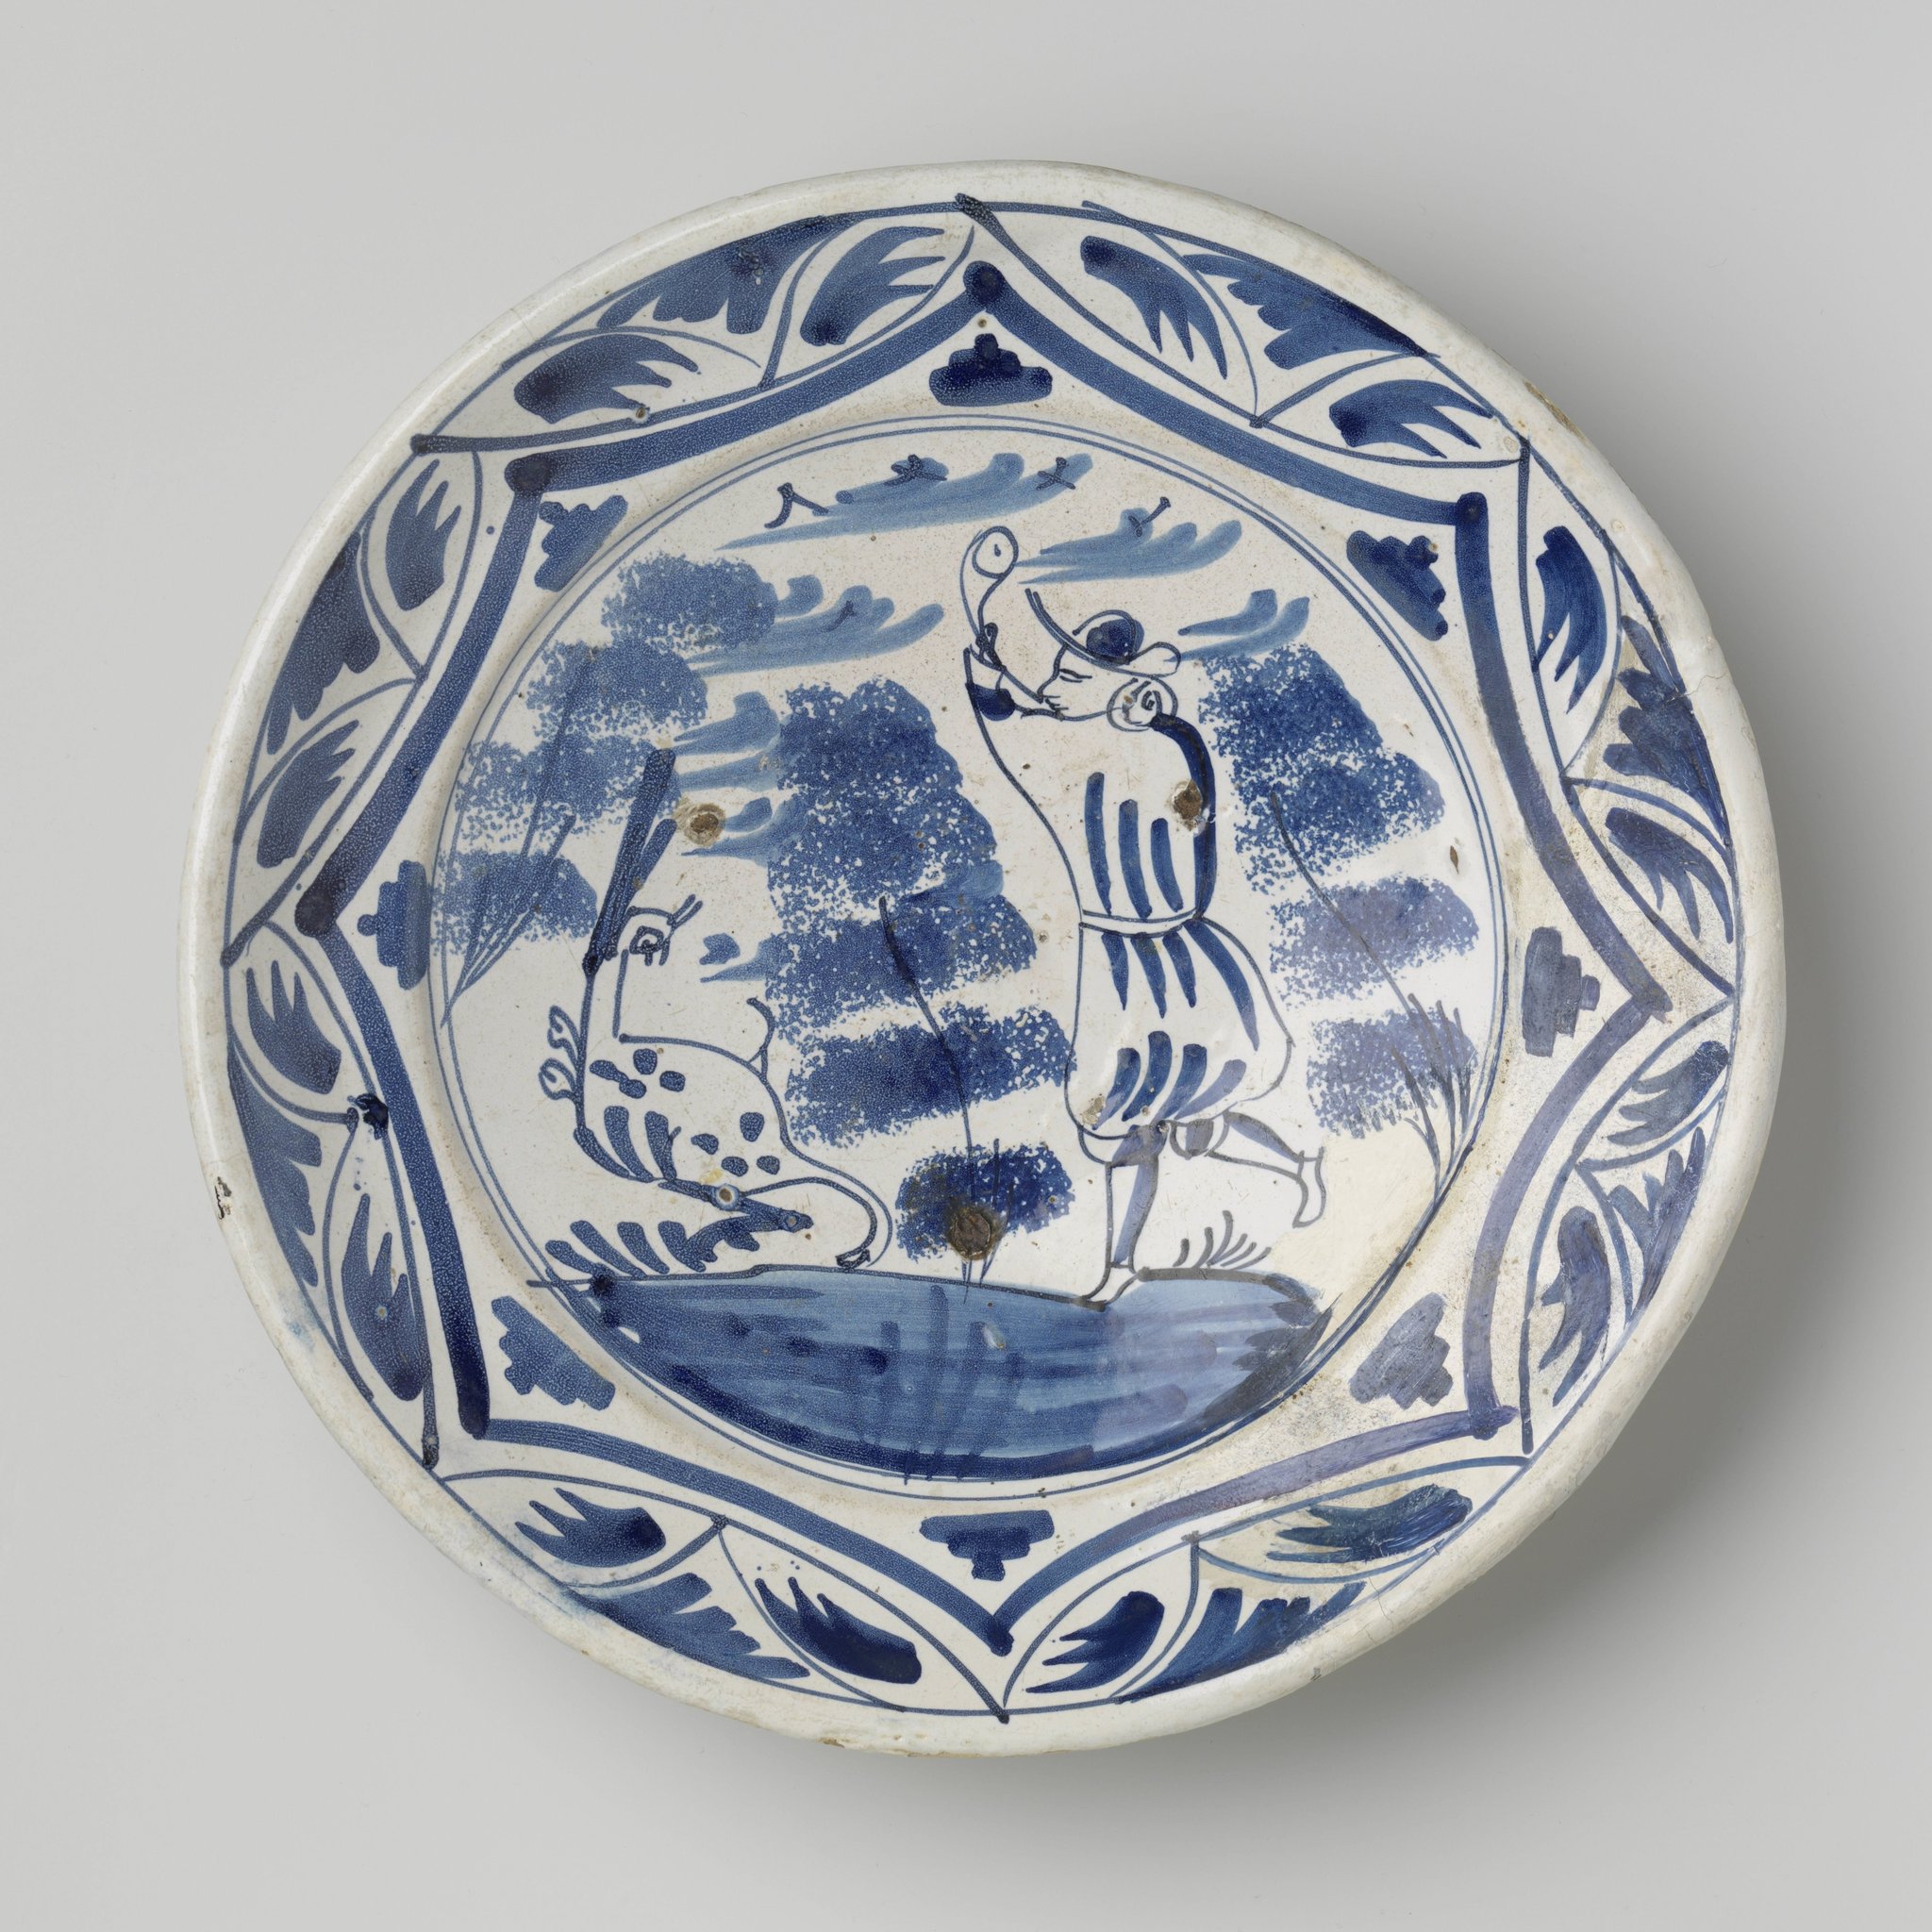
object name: platter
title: Schotel van blauw beschilderde majolica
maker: Anonymous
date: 1725-1775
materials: earthenware, glaze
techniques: maiolica, painted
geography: delft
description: Ronde schotel van blauw beschilderde majolica. Op het plat is een landschap geschilderd waarin een naar links lopende man, blazend op een hoorn. Voor de man loopt een dier. Op de rand zijn acht segmentbogen geschilderd en gestileerde bladeren.